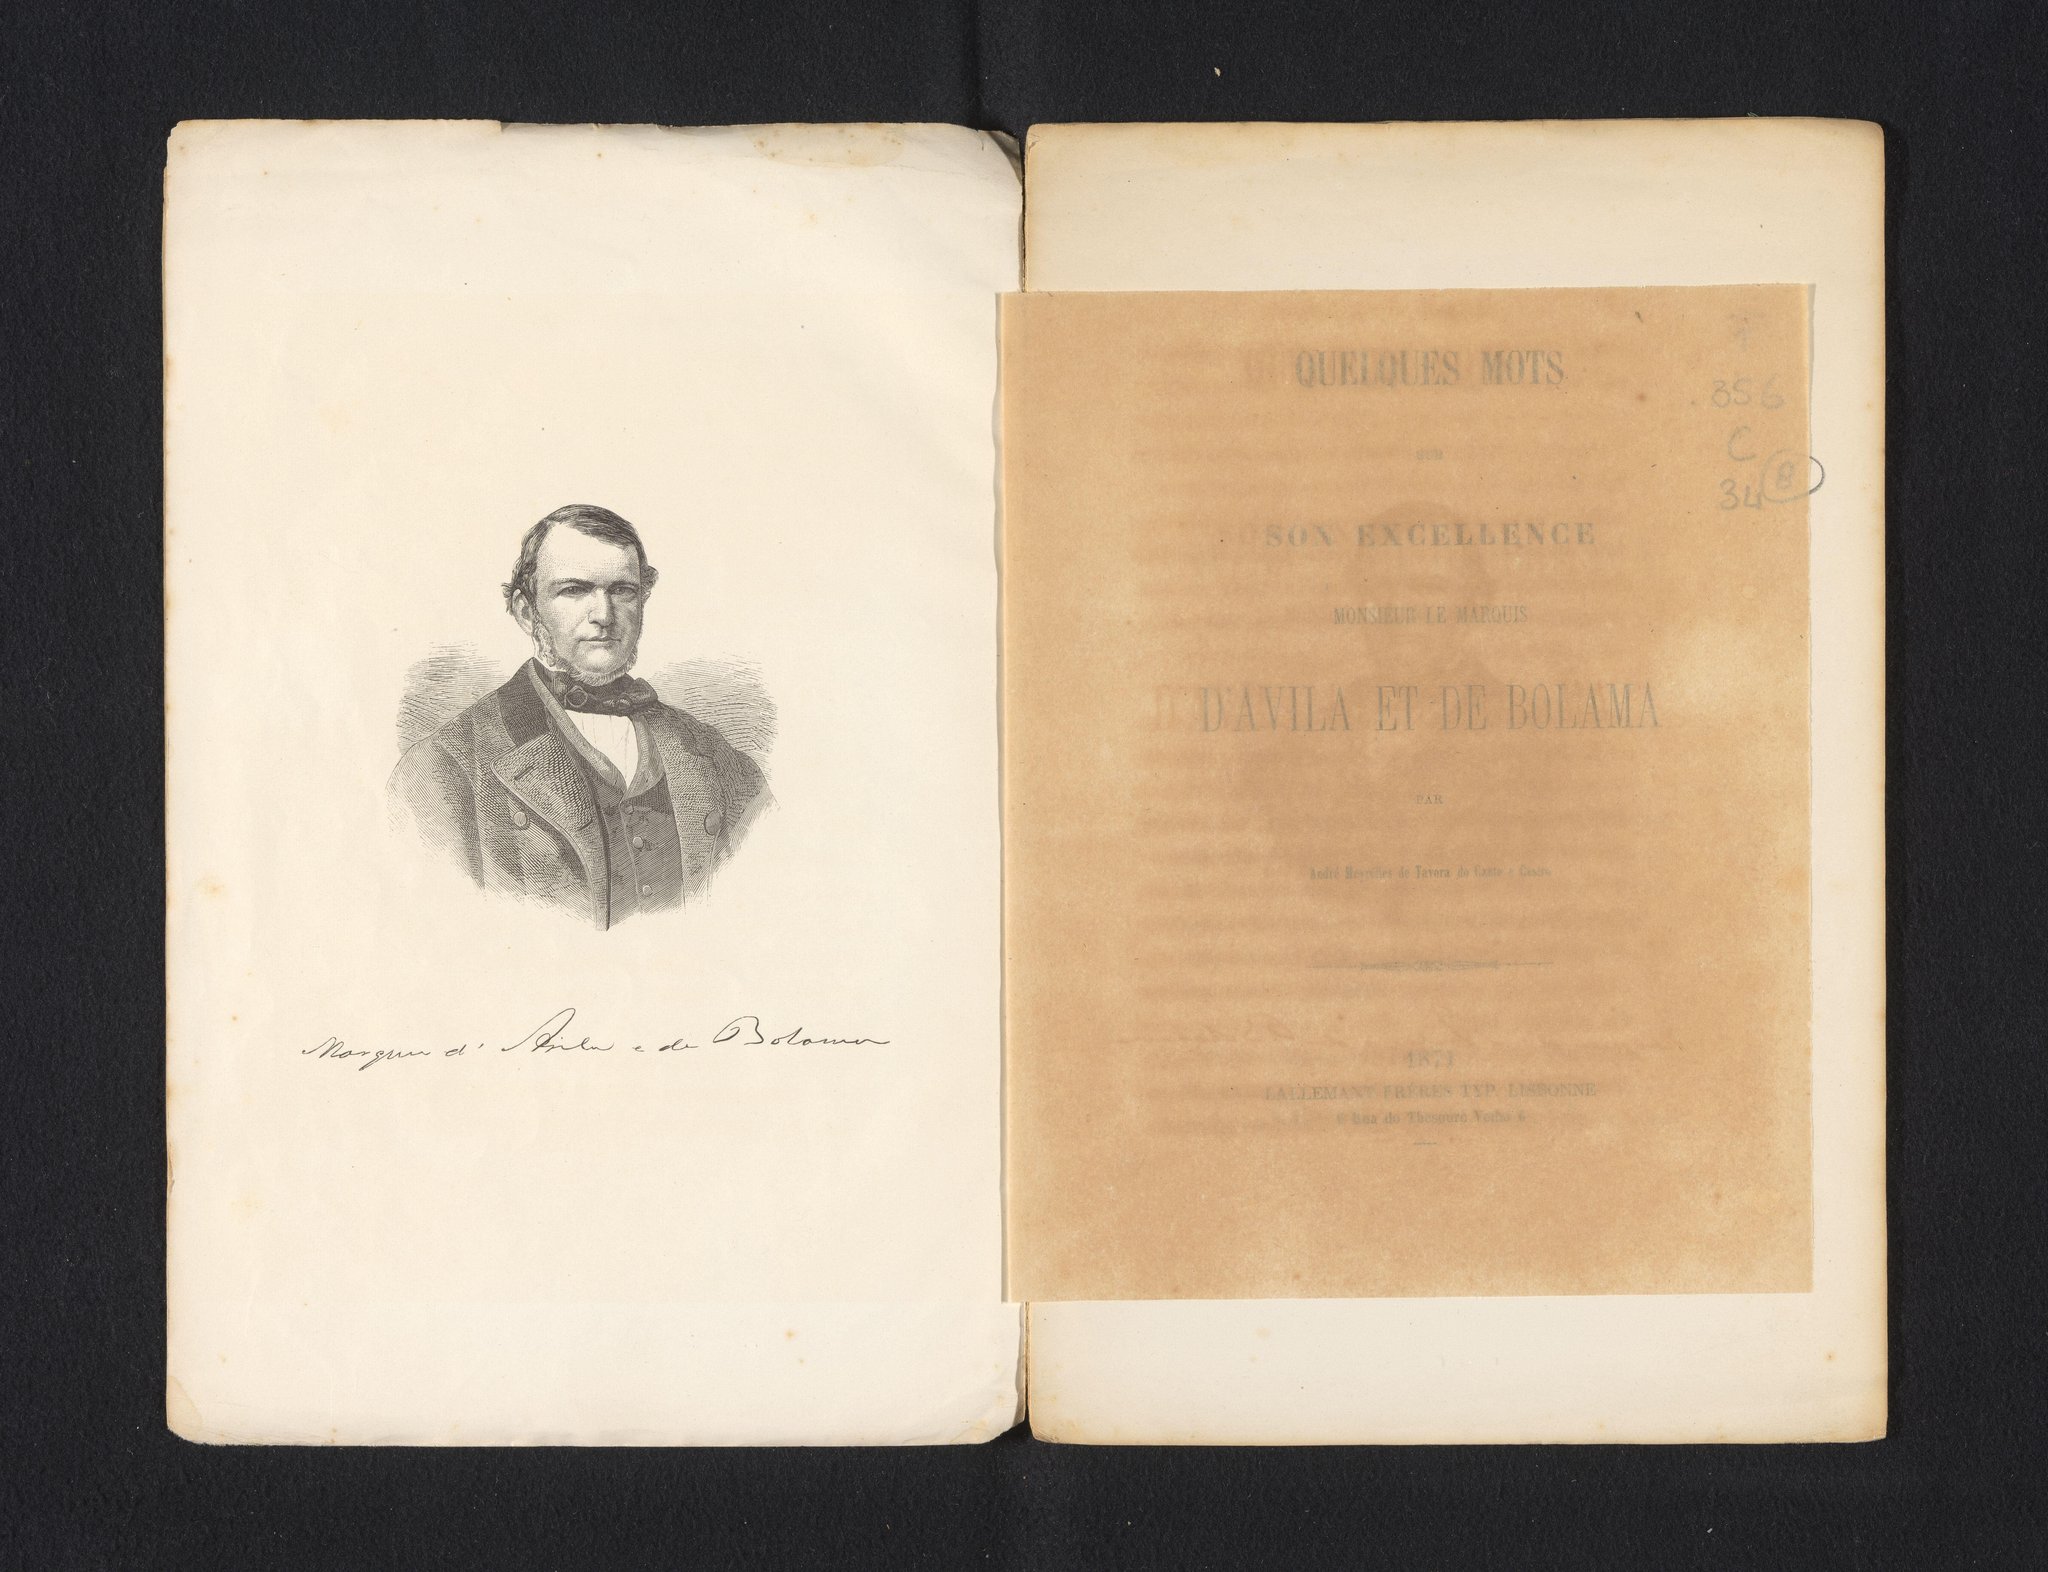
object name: page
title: Portret van de markies van Ávila en Boloma.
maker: Anonymous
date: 1866-1871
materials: photographic support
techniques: engraving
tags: politician, historical persons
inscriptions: inscription: ‘Marquis d'Avila et de Boloma’